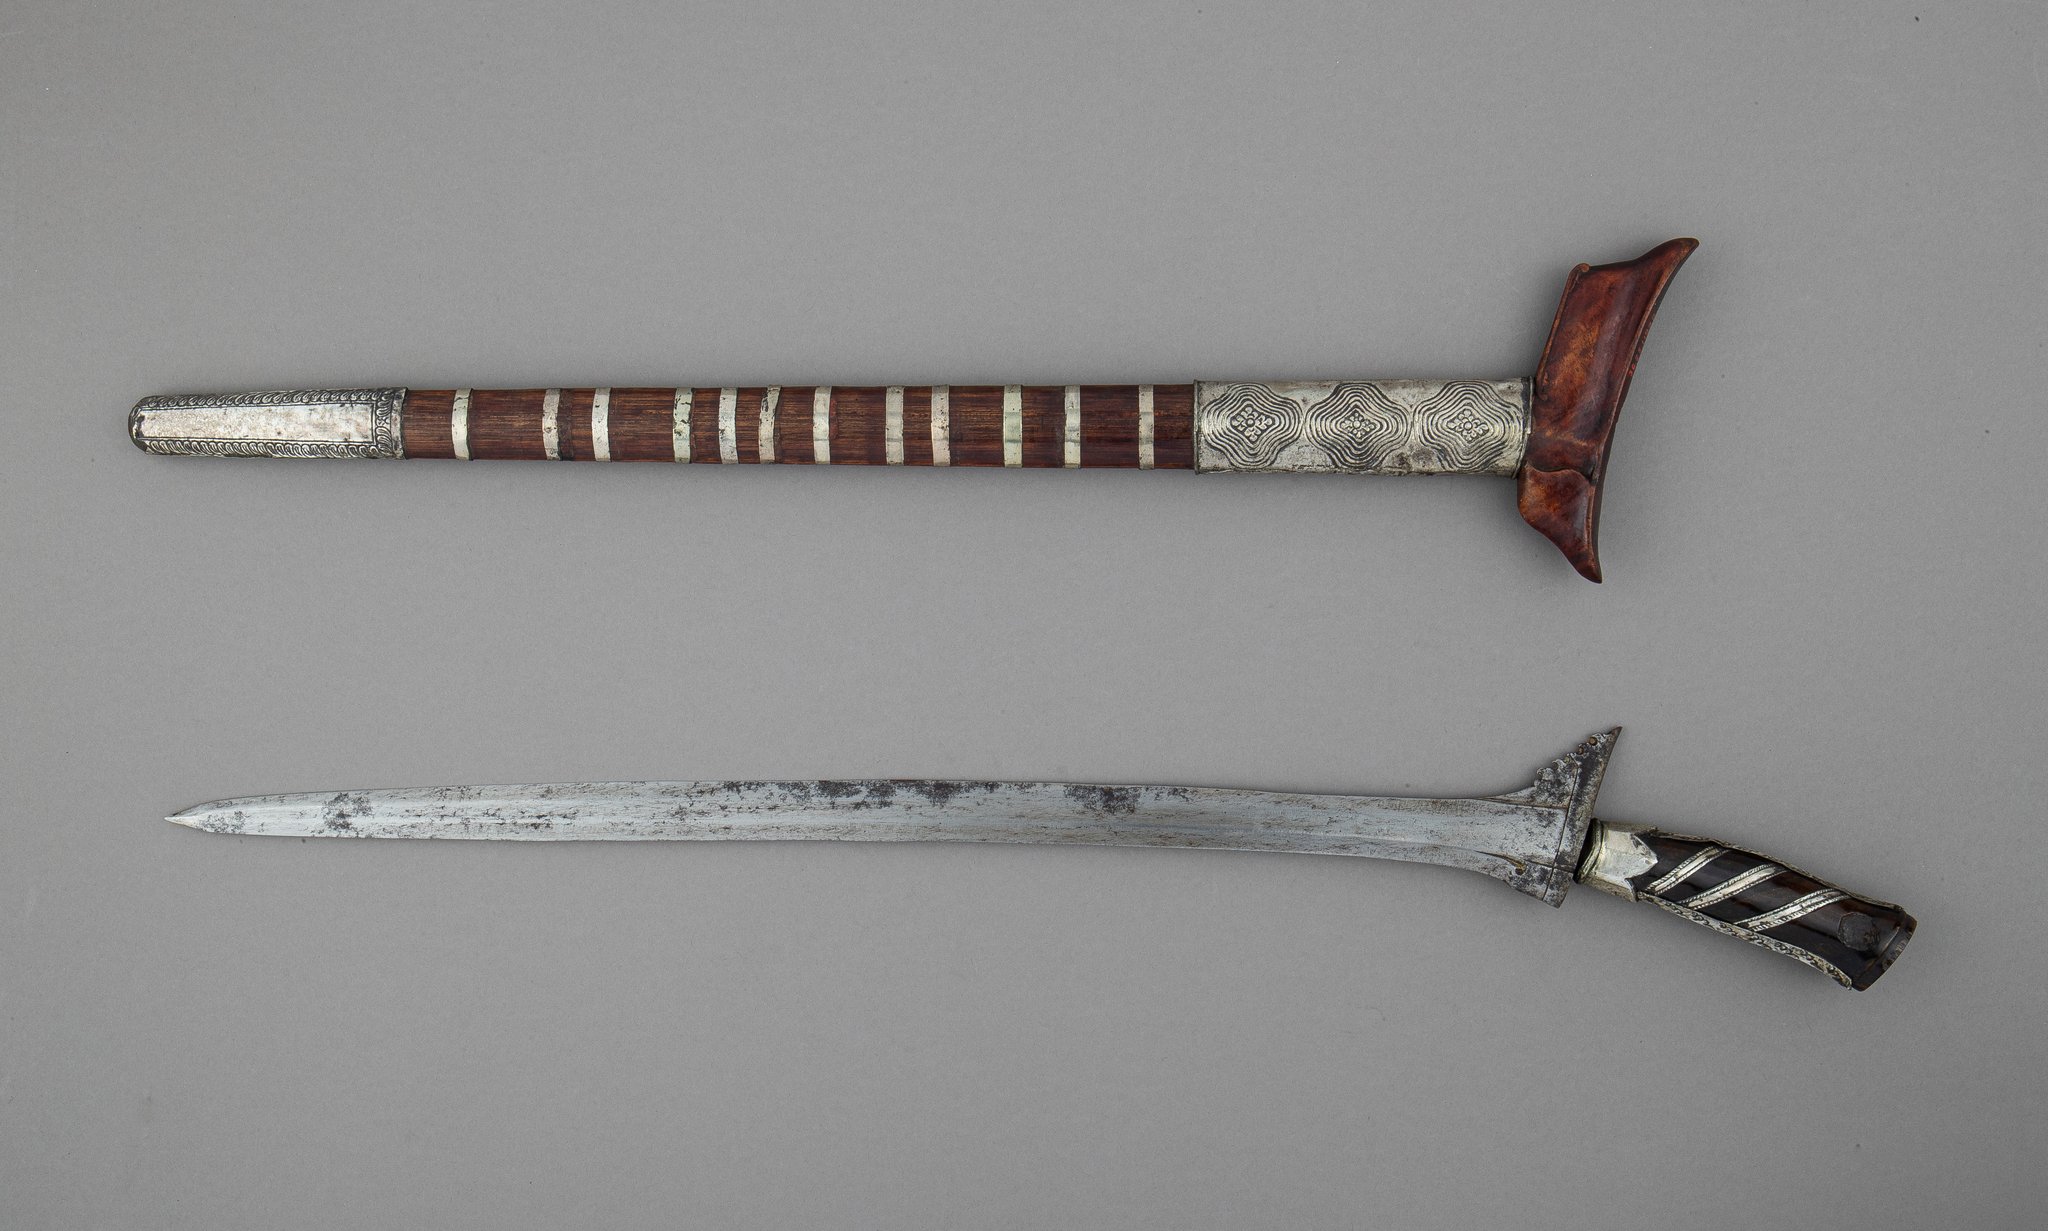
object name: executioner's kris with sheath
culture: sumatran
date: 1501-1900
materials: silver, steel, wood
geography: indonesia